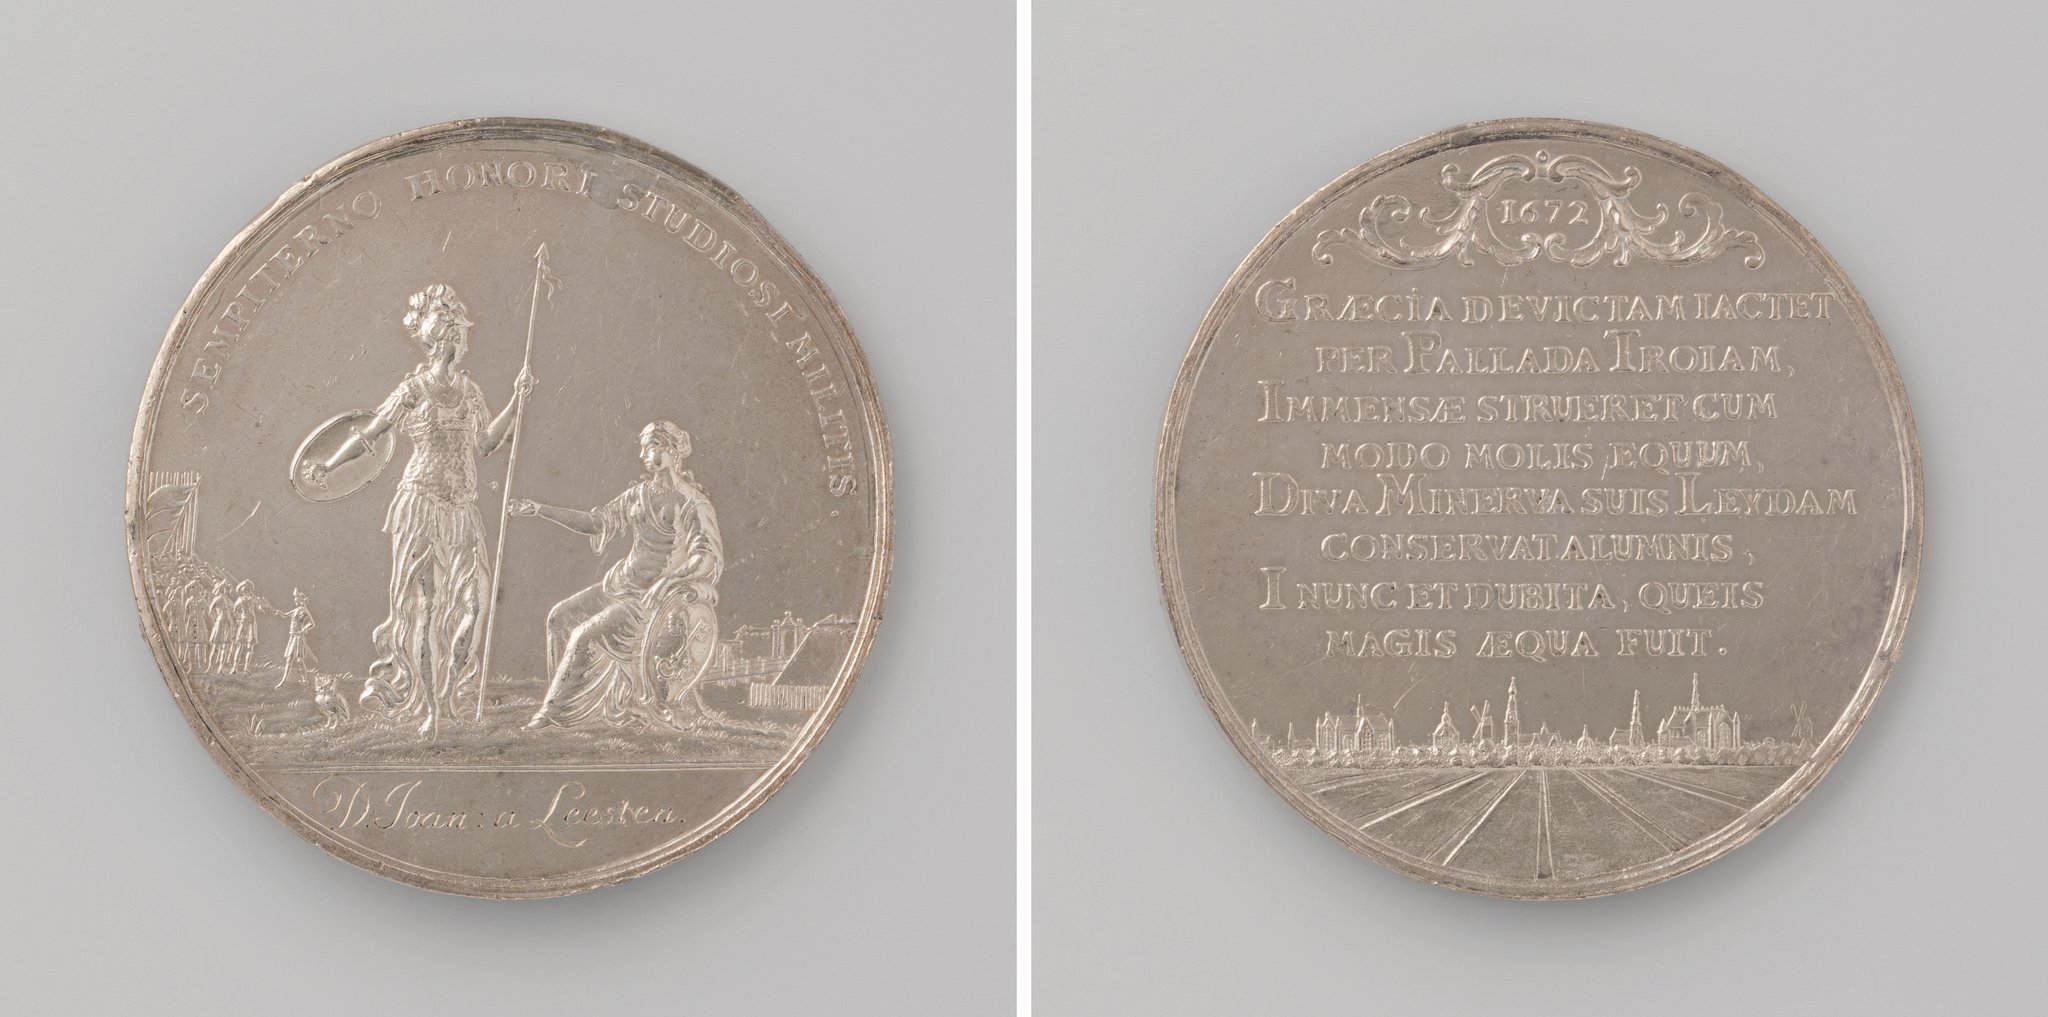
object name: history medal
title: Door de burgemeesters van Leiden aan de gewapende studenten vereerd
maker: Anonymous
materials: silver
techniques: engraving, striking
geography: leiden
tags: leiden, rampjaar (disaster year)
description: Zilveren penning. Voorzijde: staande Pallas met schild en speer biedt aan zittende Leiden met wapenschild een groep studenten aan binnen omschrift. Keerzijde: opschrift boven gezicht op stad.